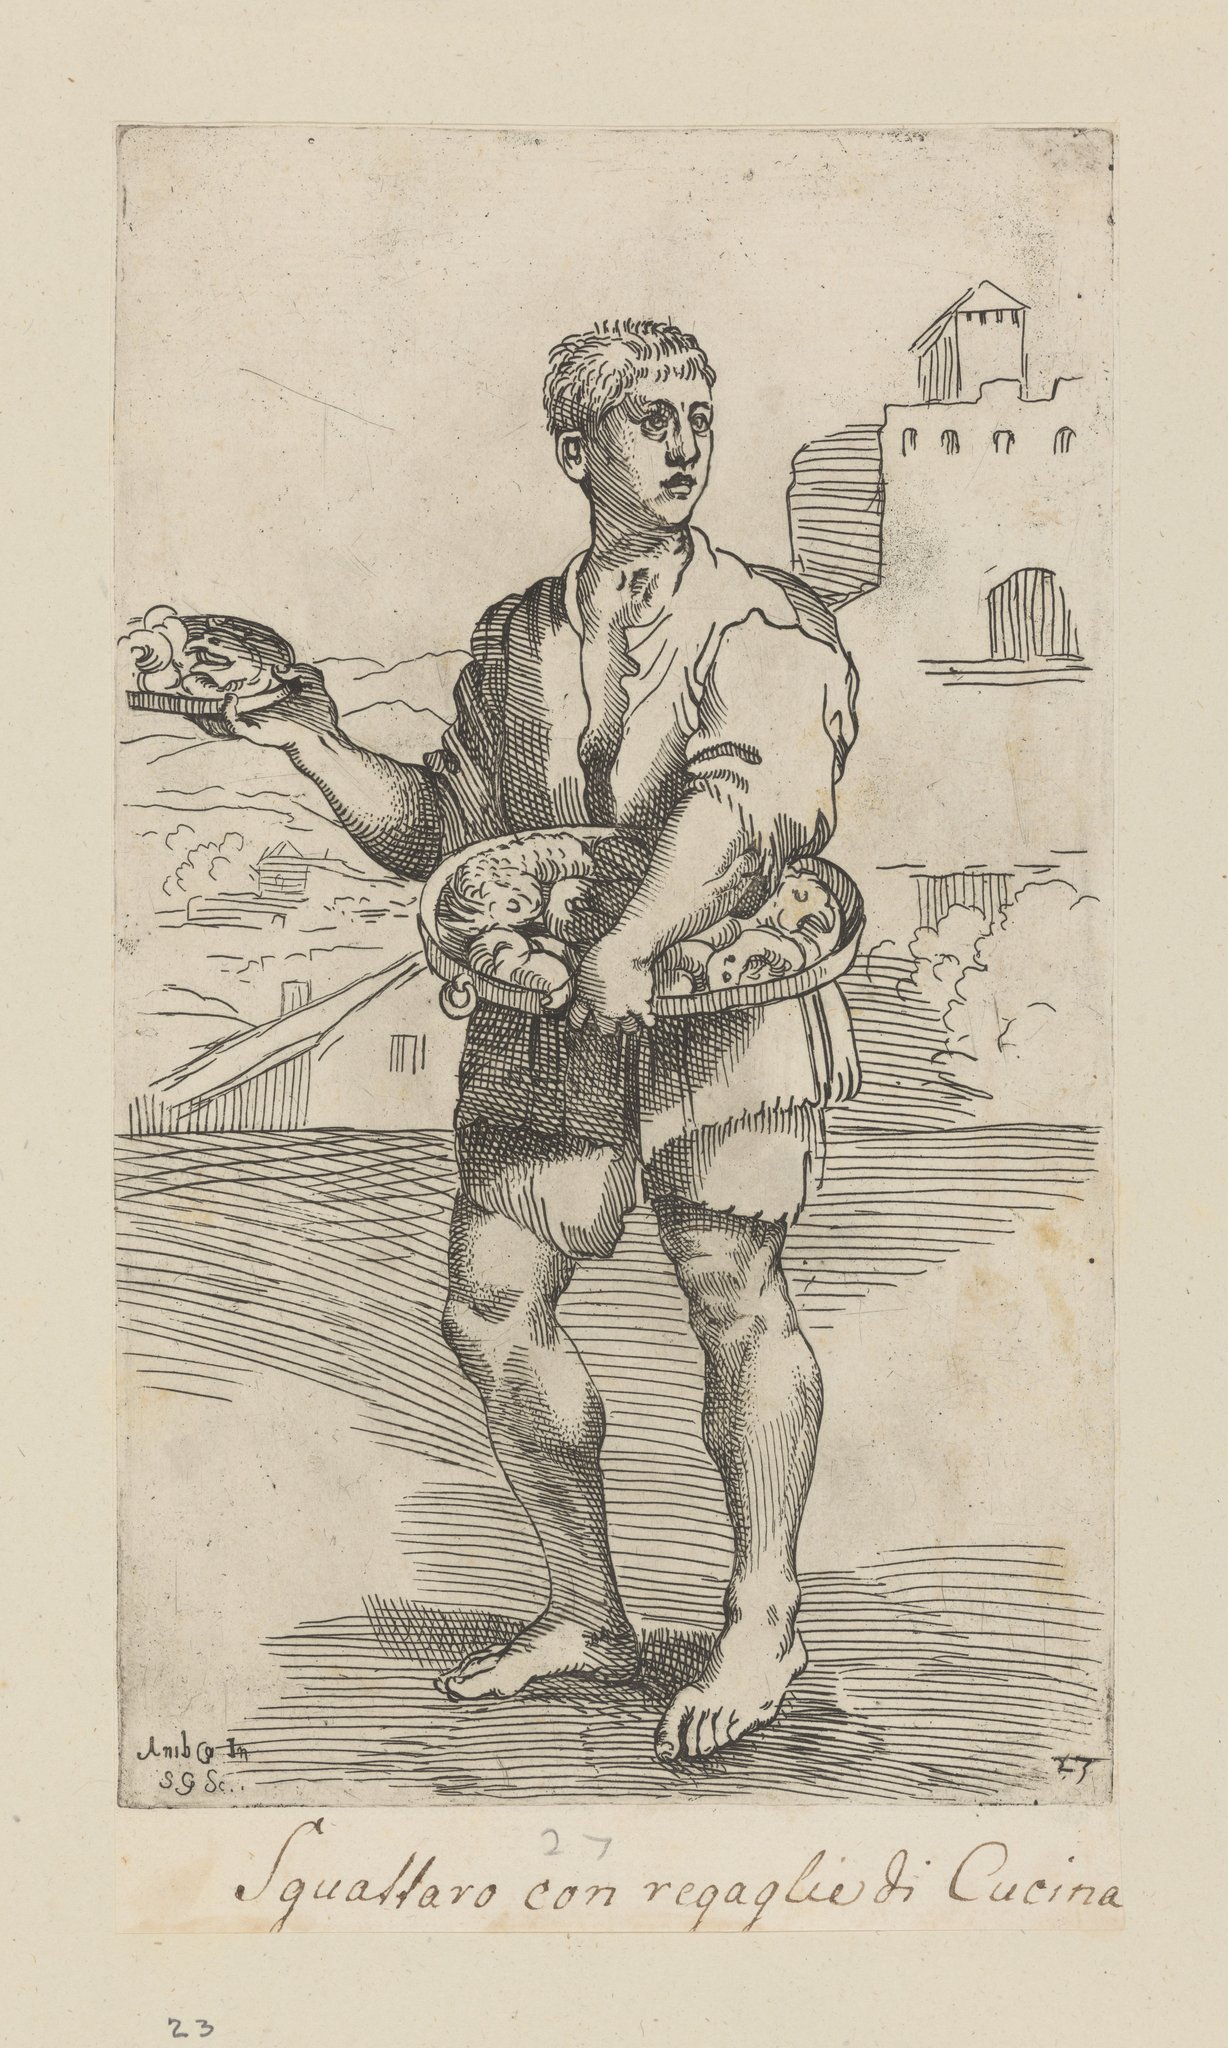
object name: print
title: Plate 23: Vendor of kitchen scraps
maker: simon guillain ii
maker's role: artist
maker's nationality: french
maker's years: 1618-1718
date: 1646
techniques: etching